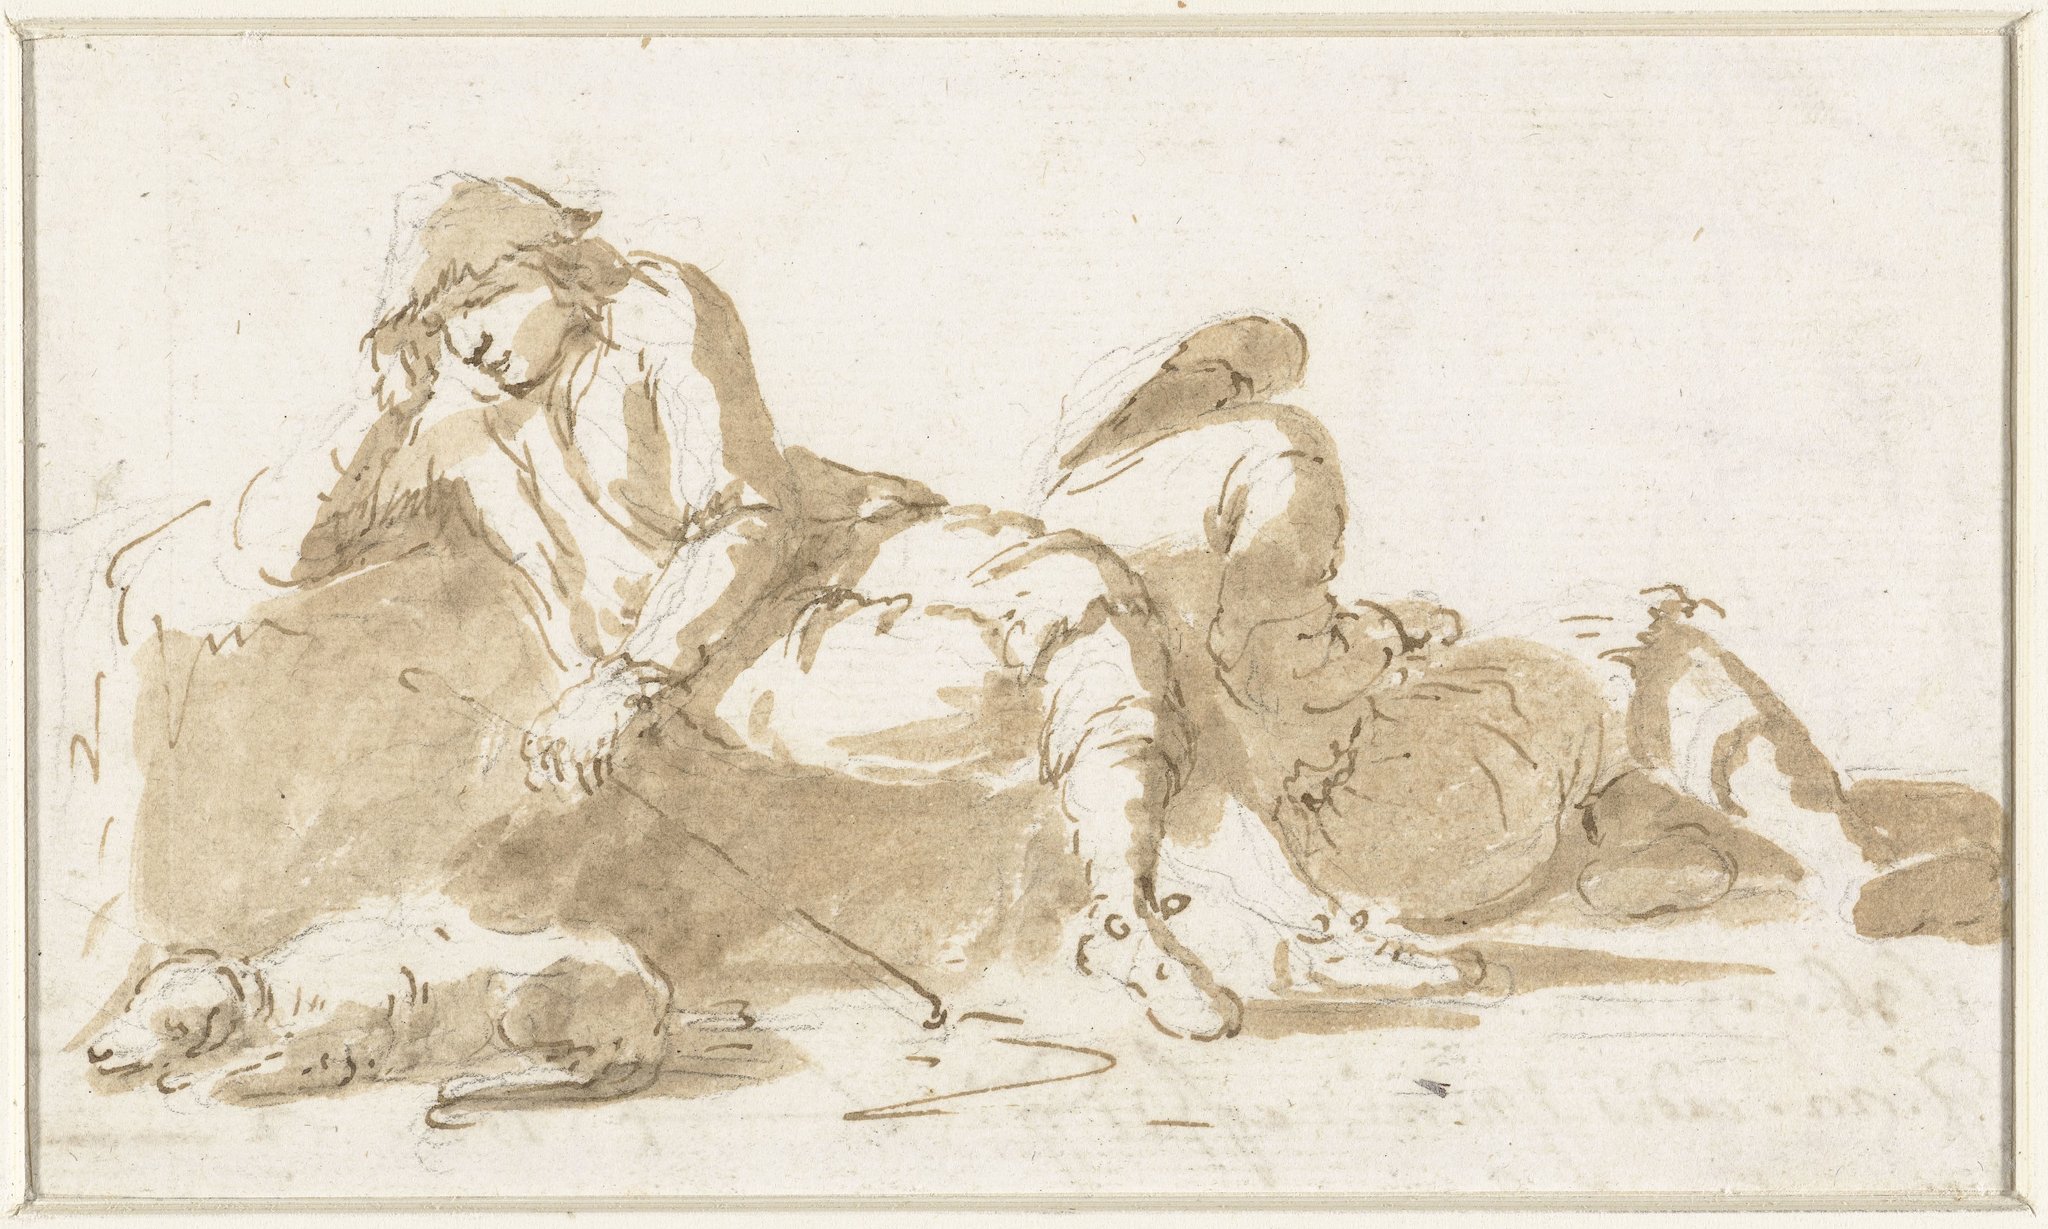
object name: drawing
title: Twee rustende herders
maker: salvator rosa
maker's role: draughtsman, painter, print maker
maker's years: 1615-1673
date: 1636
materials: chalk, ink, paper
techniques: brush, pen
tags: herding, herdsman, herdswoman, shepherd, shepherdess, cowherd, etc., sleeping on the ground - bb - out of doors